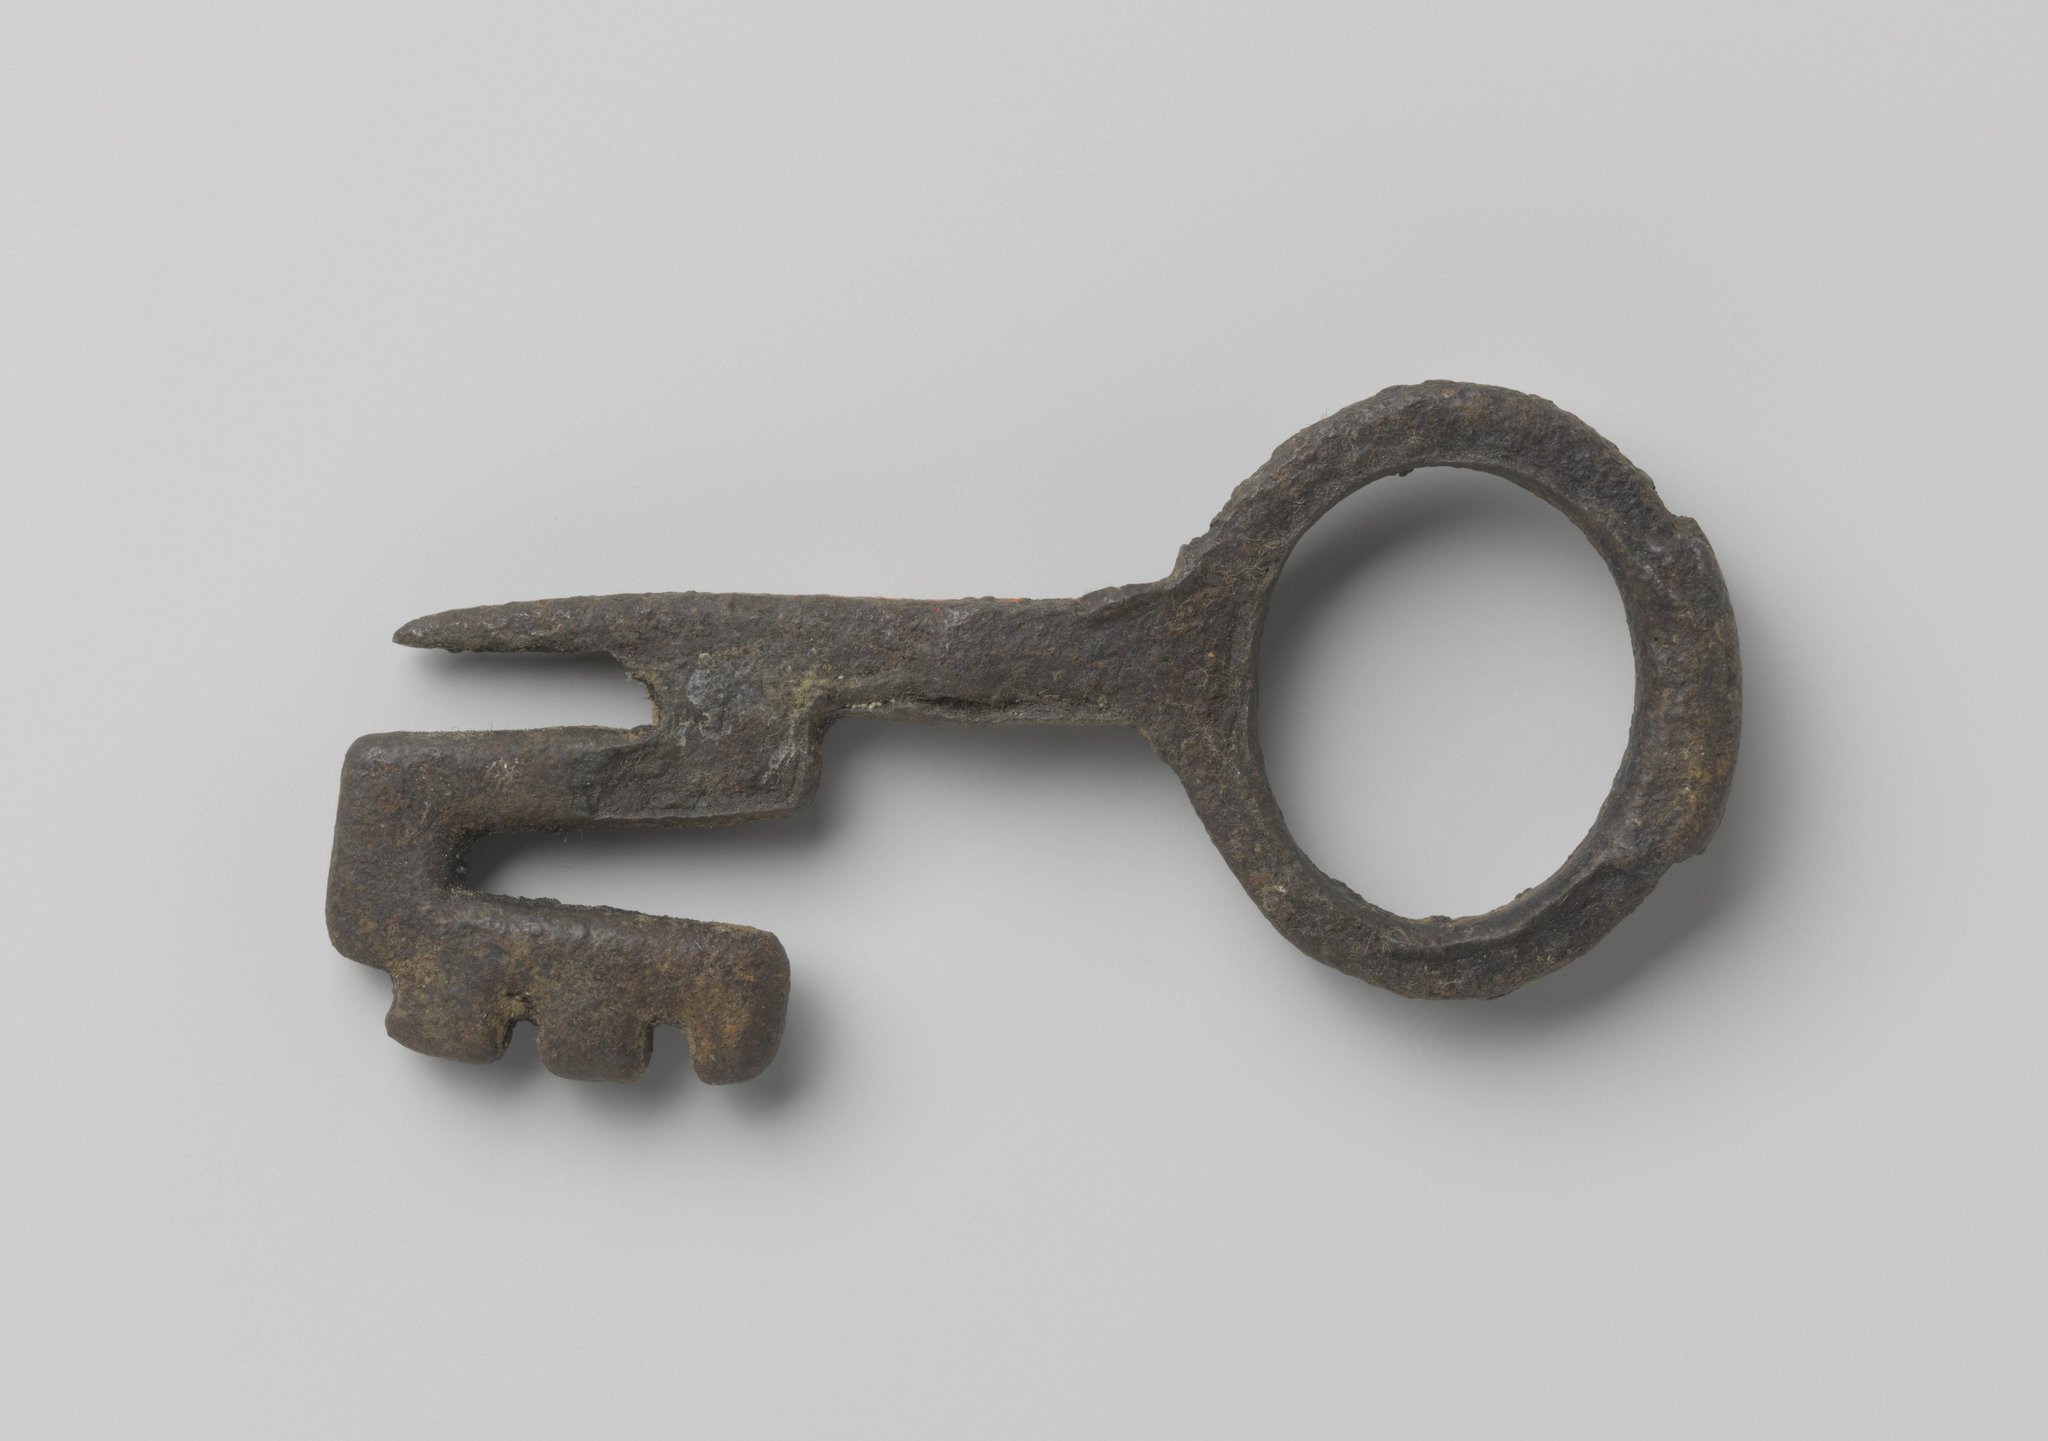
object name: key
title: Sleutel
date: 1500-1600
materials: iron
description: Sleutel waarvan de korte steel puntig toeloopt. Het oog is ringvormig.